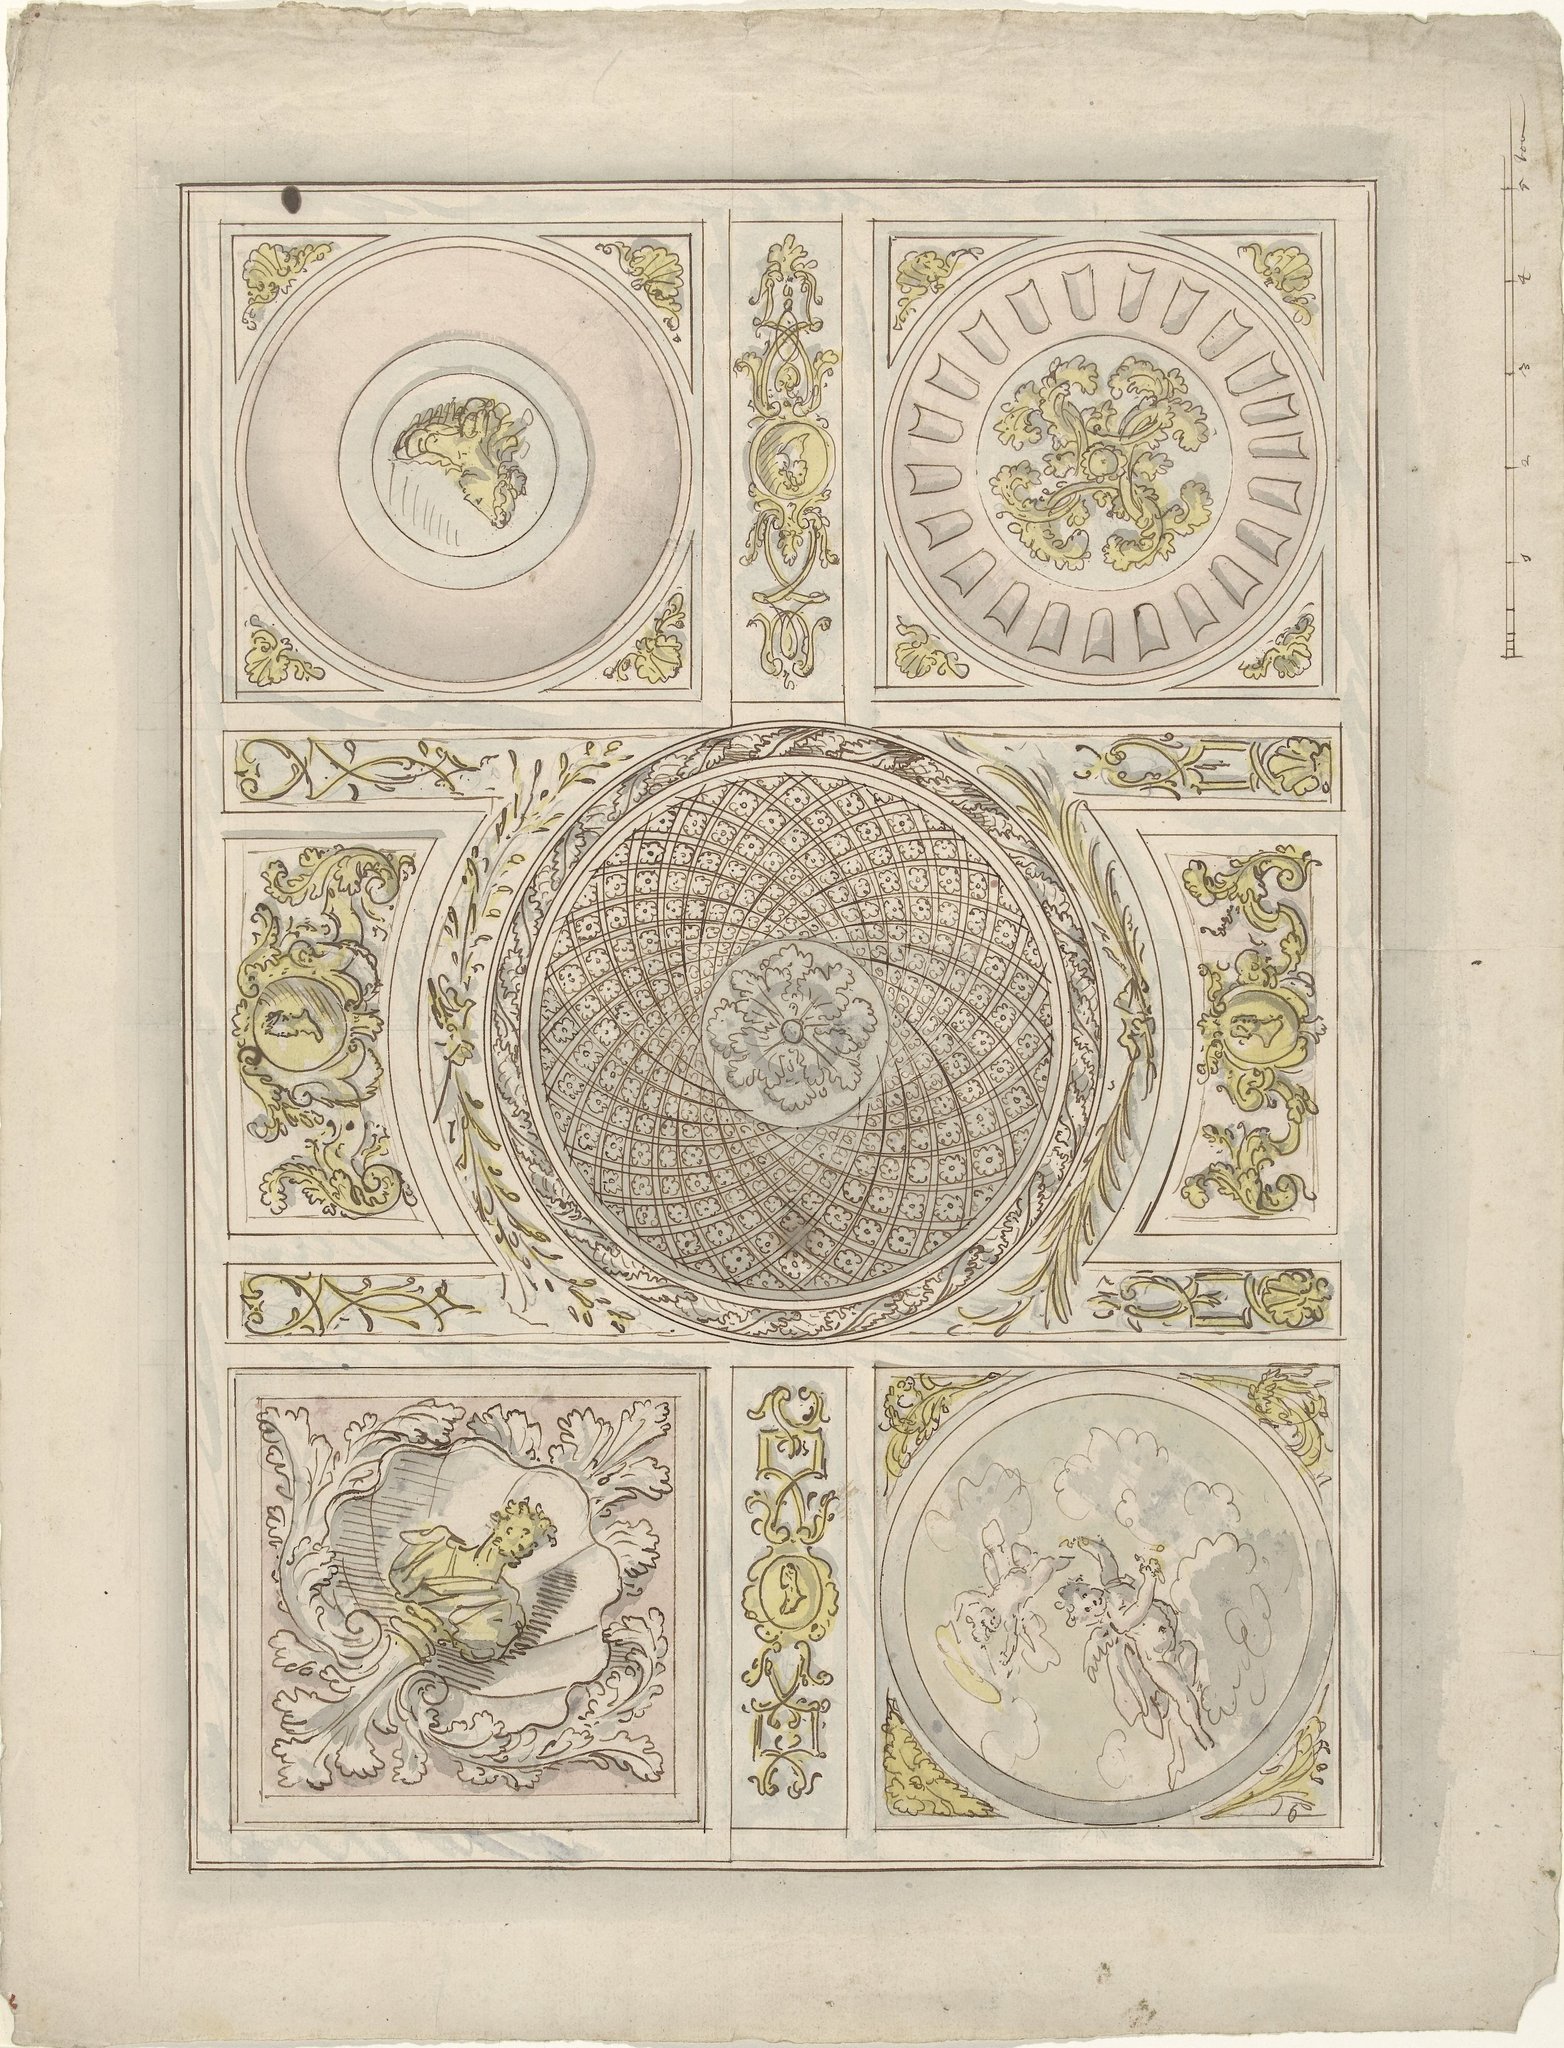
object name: design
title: Ontwerp voor een plafondschildering: ornamentale vlakvulling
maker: elias van nijmegen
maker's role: draughtsman, painter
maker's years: 1667-1755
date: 1677-1755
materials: ink, paper, pencil, watercolor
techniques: brush, pen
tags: (decorated) ceiling